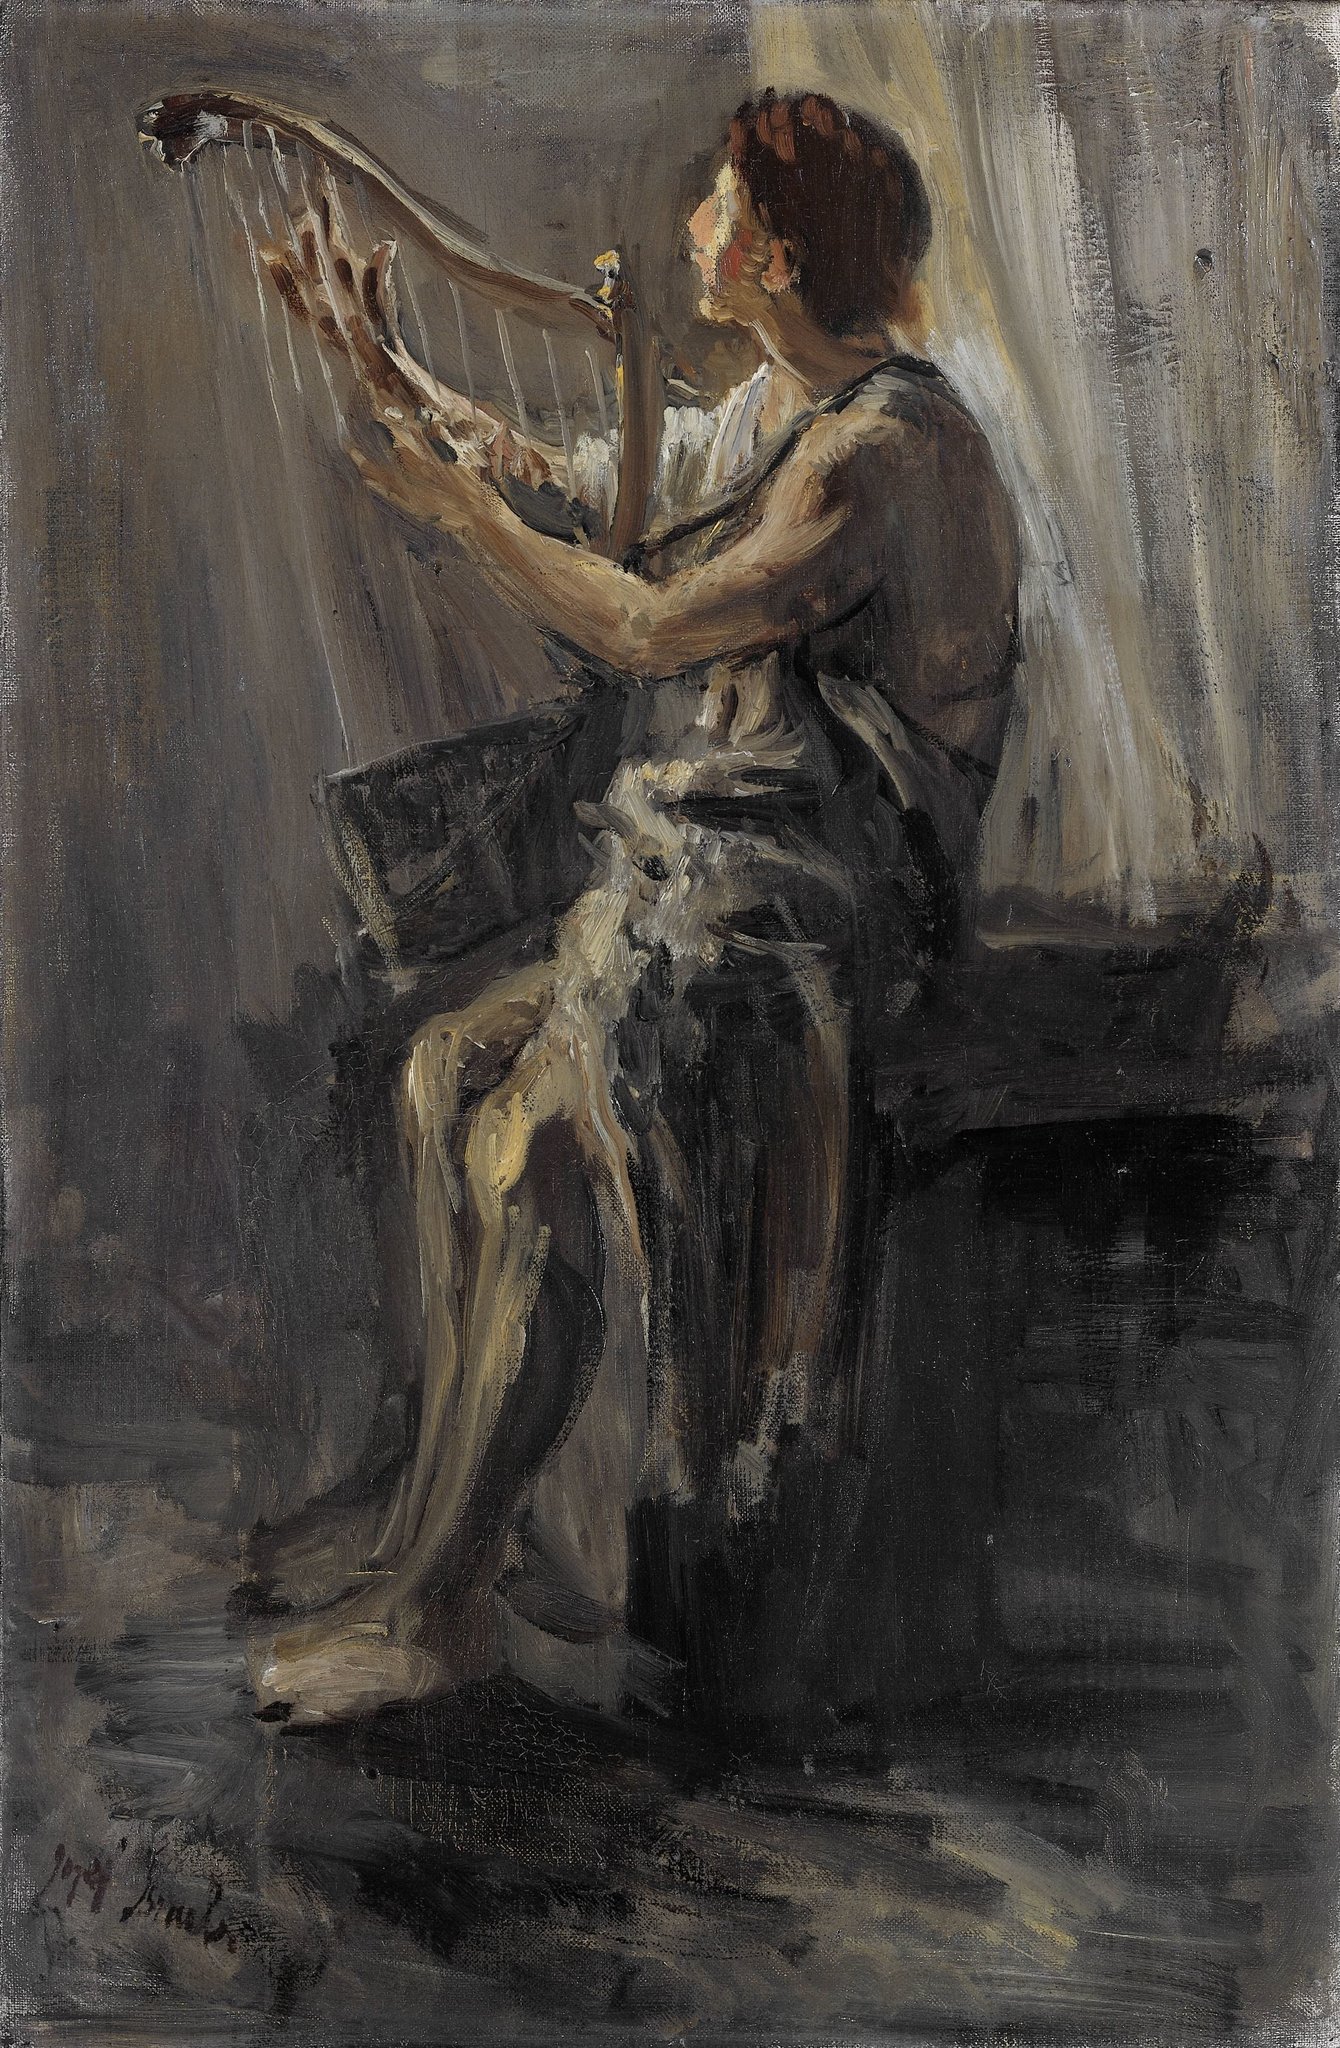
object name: painting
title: David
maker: jozef israëls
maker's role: draughtsman, painter, print maker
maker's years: 1824-1911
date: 1899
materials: canvas, oil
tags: david playing his harp before saul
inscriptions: signature: ‘Jozef Israels’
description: David spelend op een harp. Uit een reeks van vijf studies voor een schilderij van Saul en David uit 1899 (zie ook SK-A-3730, SK-A-4180, SK- A-4198 en SK-A-3732).